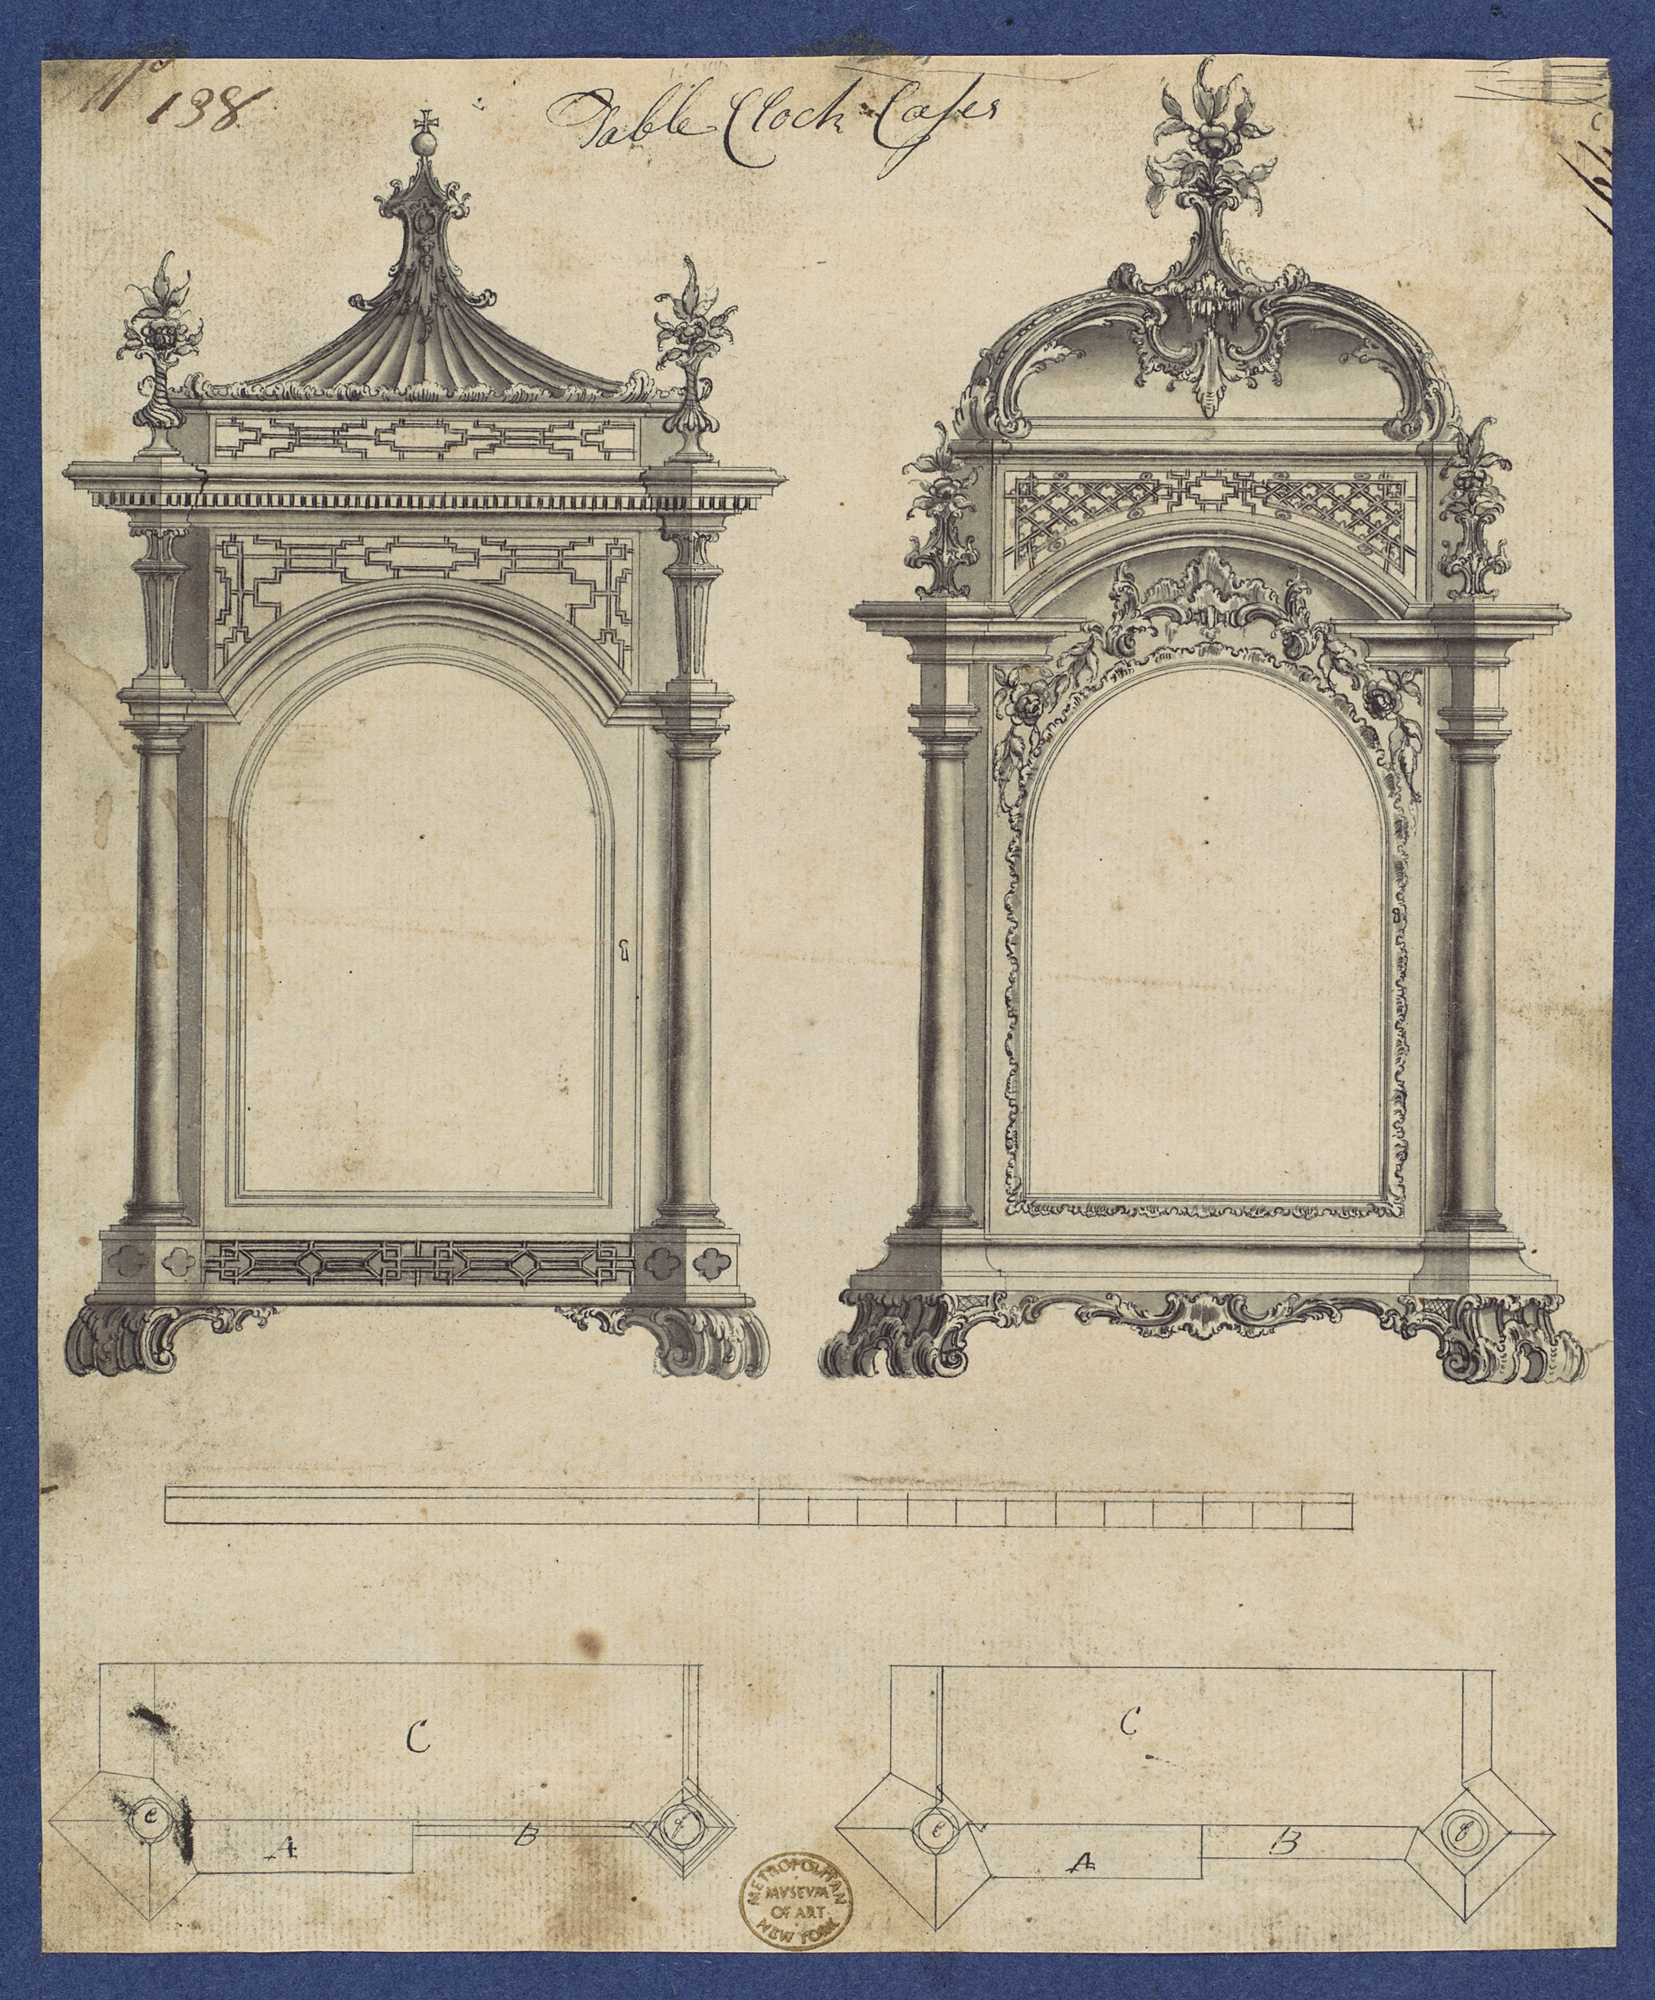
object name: drawing ornament architecture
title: Table Clock Cases, in Chippendale Drawings, Vol. I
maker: thomas chippendale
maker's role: artist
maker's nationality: british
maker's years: 1718-1779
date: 1754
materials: ink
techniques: wash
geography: london